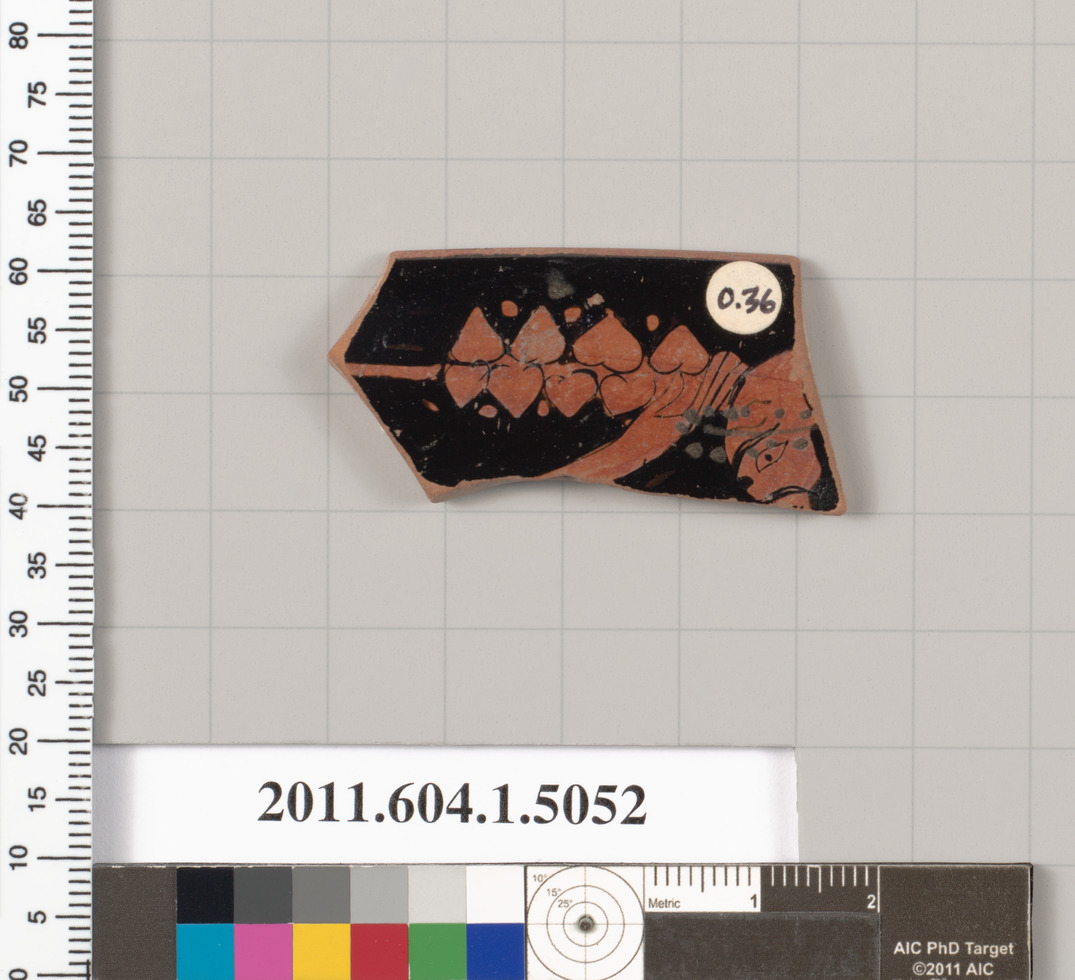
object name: kylix fragment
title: Terracotta fragment of a kylix (drinking cup)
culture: greek, attic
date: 520-500 BCE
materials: terracotta